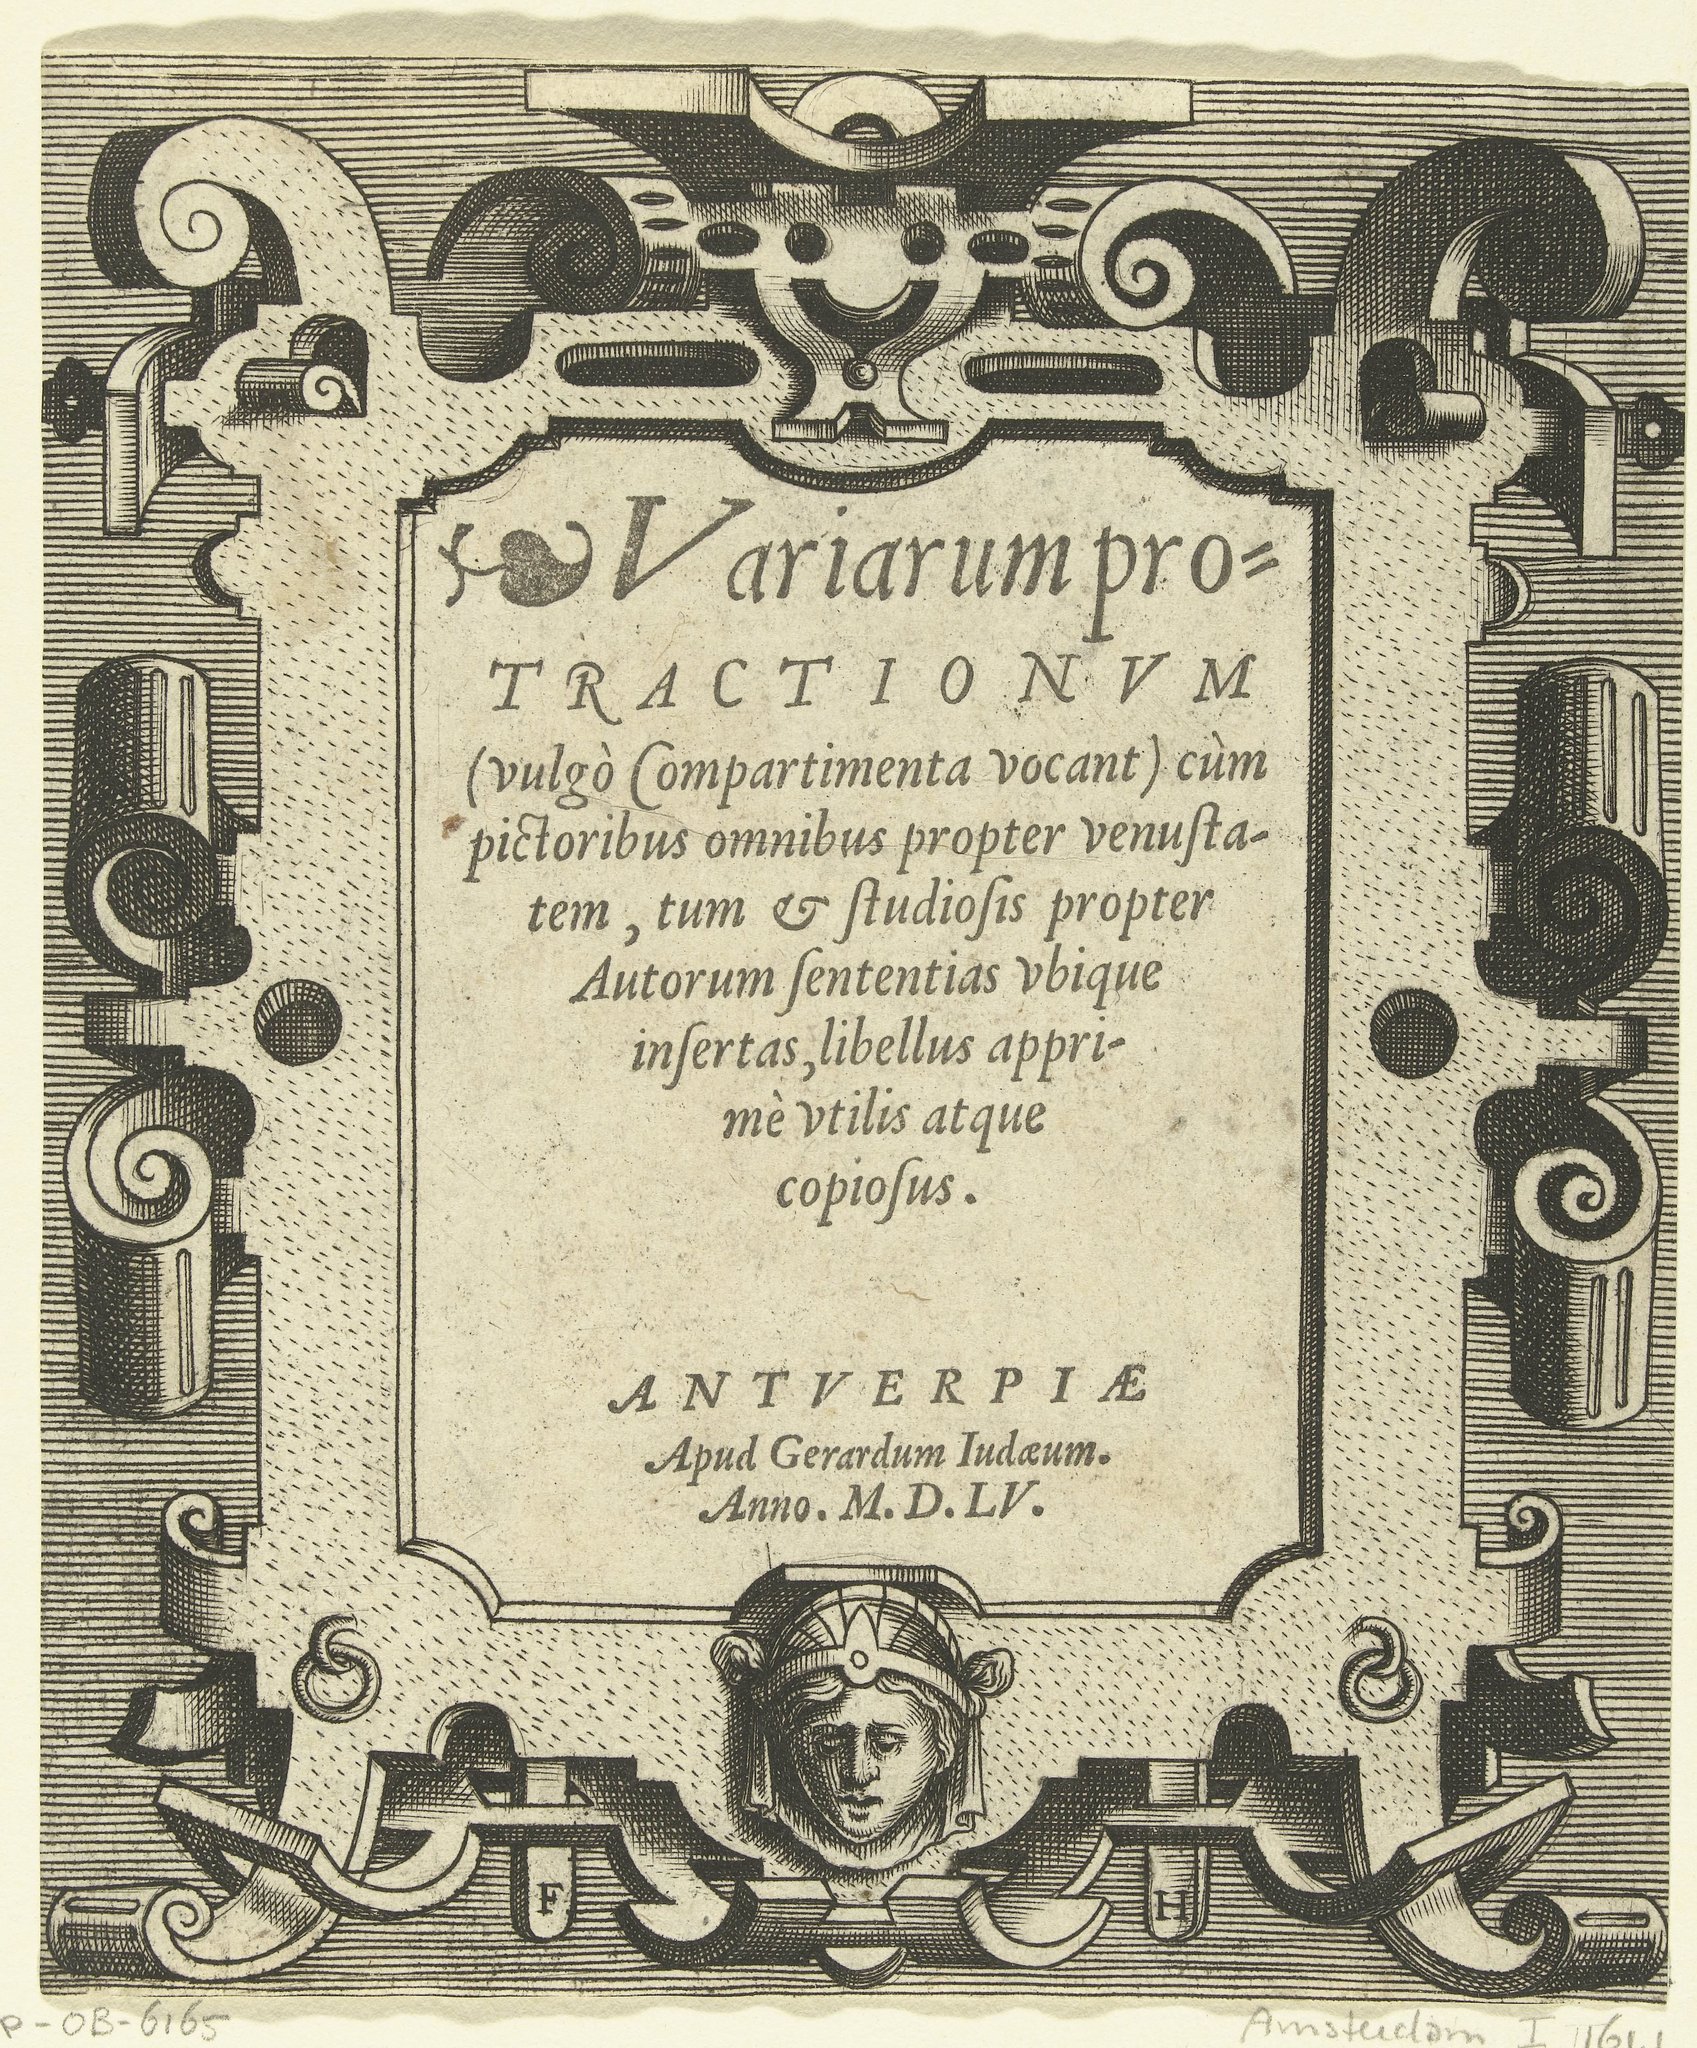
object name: ornament print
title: Variarum protractionum (...)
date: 1555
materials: paper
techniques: etching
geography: netherlands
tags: title-page, mask, mascaron ~ ornament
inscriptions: date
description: Rechthoekig staand cartouche met titel in het centrale compartiment. Gearceerde achtergrond. Titelblad van serie die bestaat uit titelblad en 12 bladen met cartouches met citaten van klassieke schrijvers in een omlijsting van rolwerk met grotesken, mascarons en guirlandes.